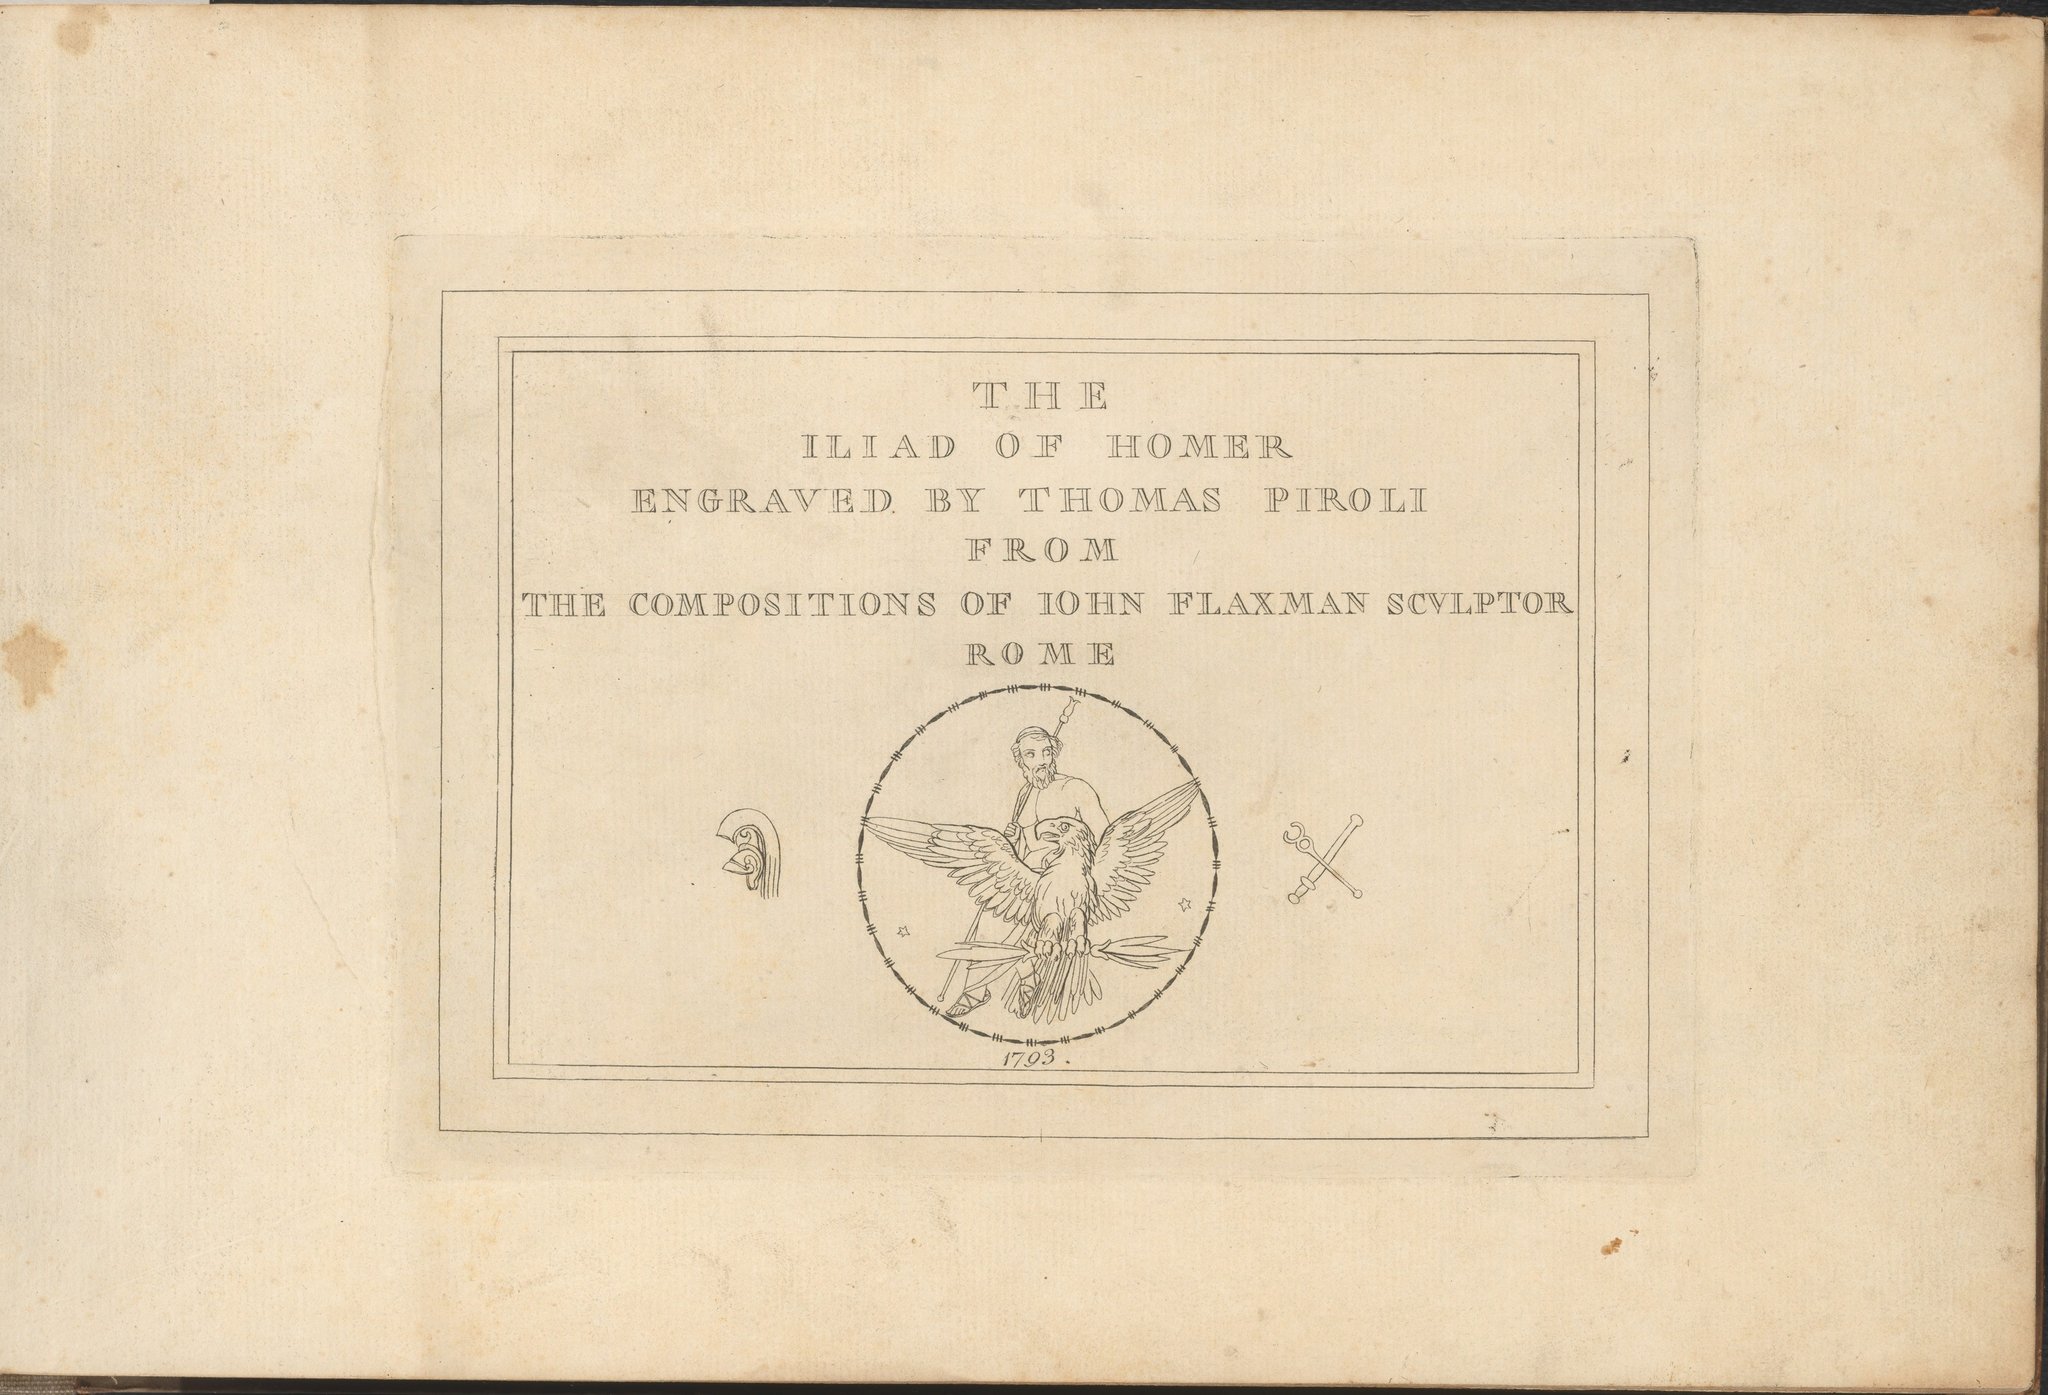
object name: book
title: The Iliad and Odyssey of Homer, Engraved From the Compositions of John Flaxman, Sculptor, Rome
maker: john flaxman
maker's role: artist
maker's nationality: british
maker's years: 1755-1826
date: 1793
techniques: engraving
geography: italy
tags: eagles,men